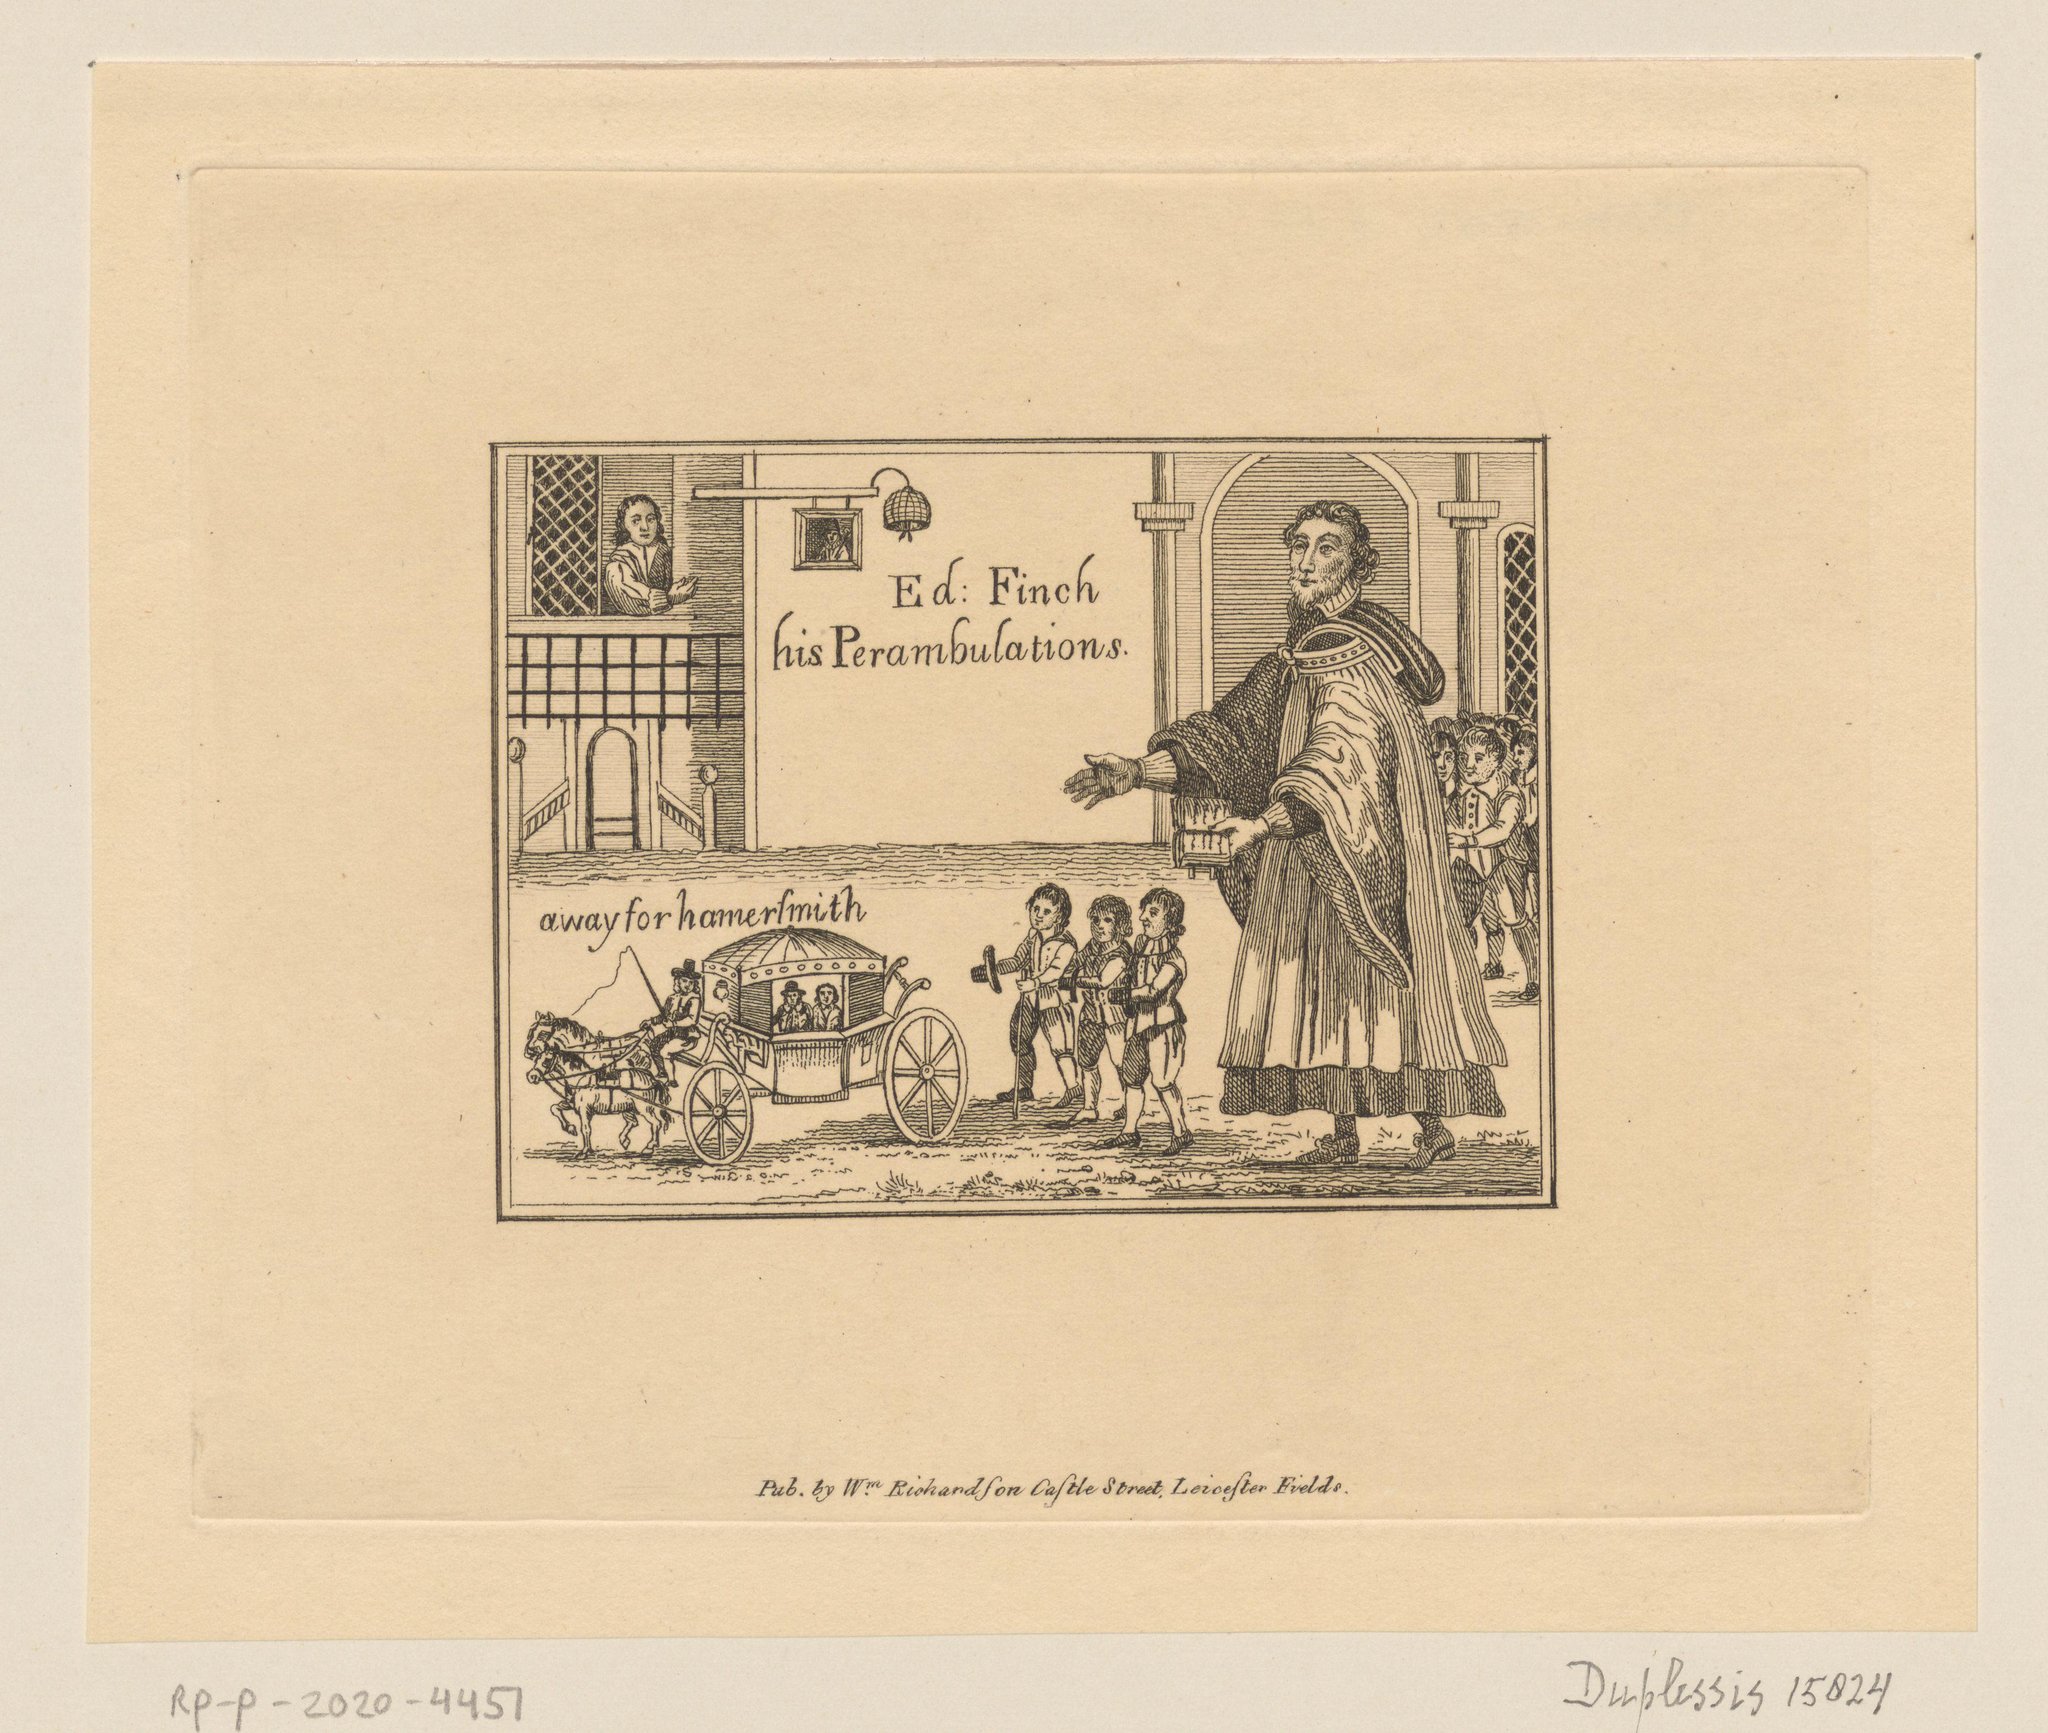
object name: print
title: Portret van Edward Finch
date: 1794-1795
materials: paper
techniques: etching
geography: london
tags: clergyman, historical persons, four-wheeled vehicle drawn by two animals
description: Finch staat op straat met een boek. Voor en achter hem staan kinderen. Hij strekt zijn armen uit richting een koets waarin twee personen zitten. Hierboven staat: away for hamersmith.